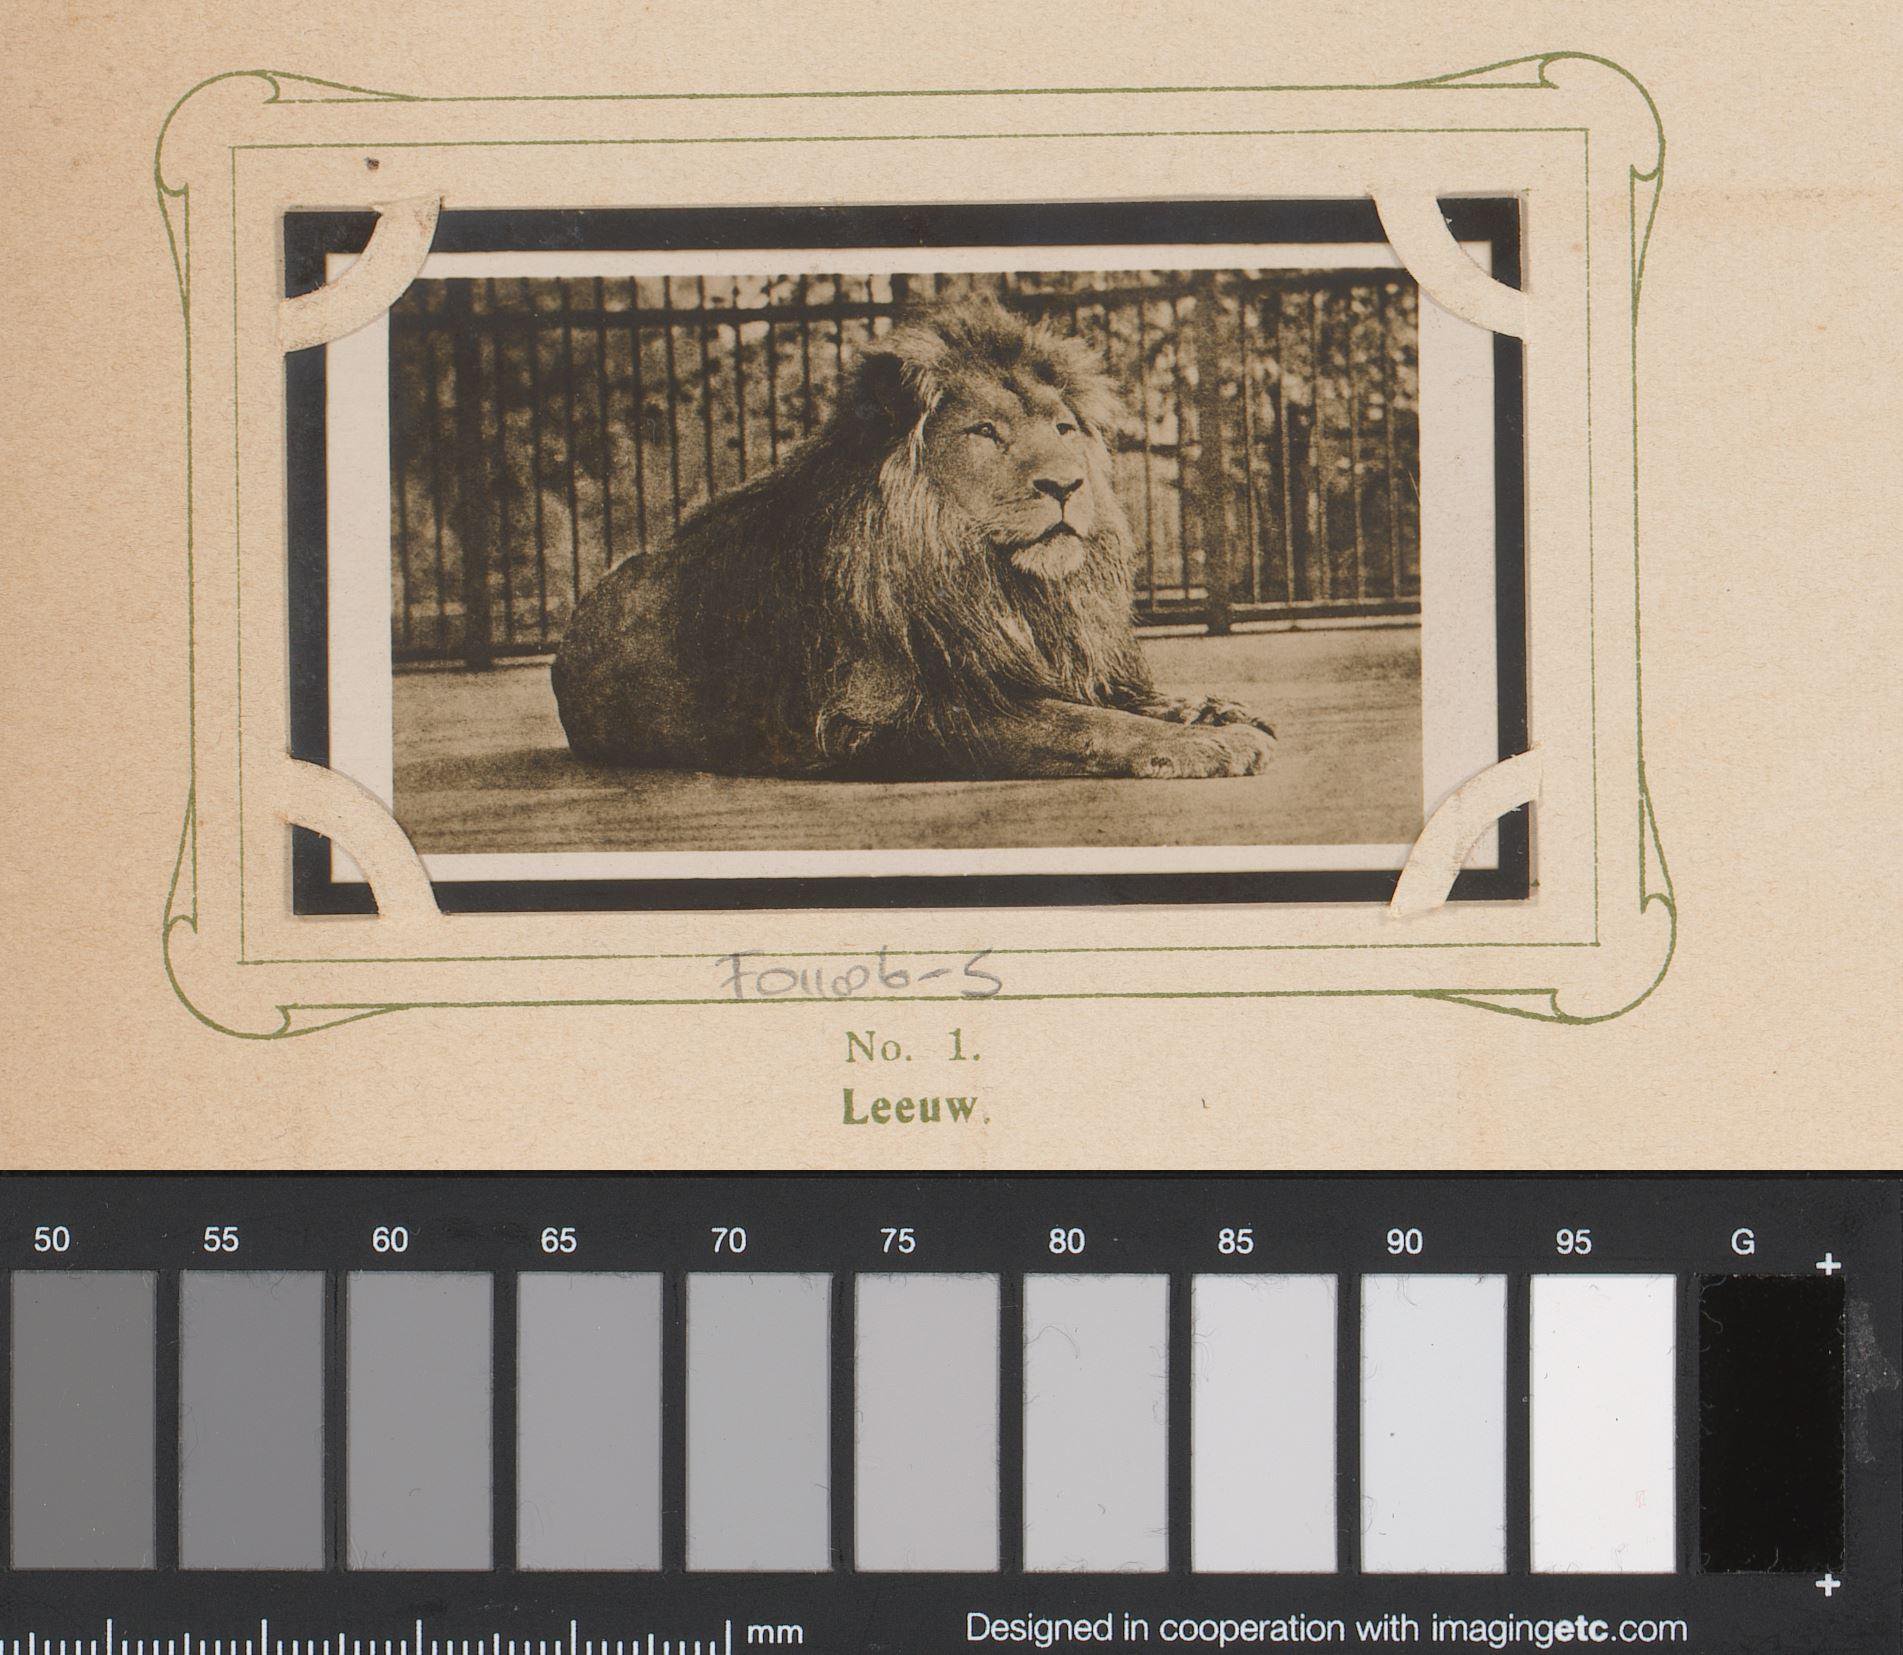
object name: album leaf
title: Liggende leeuw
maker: Anonymous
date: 1904-1905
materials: photographic support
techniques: gelatin silver print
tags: beasts of prey, predatory animals: lion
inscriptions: inscription: ‘No. 1./ Leeuw.’